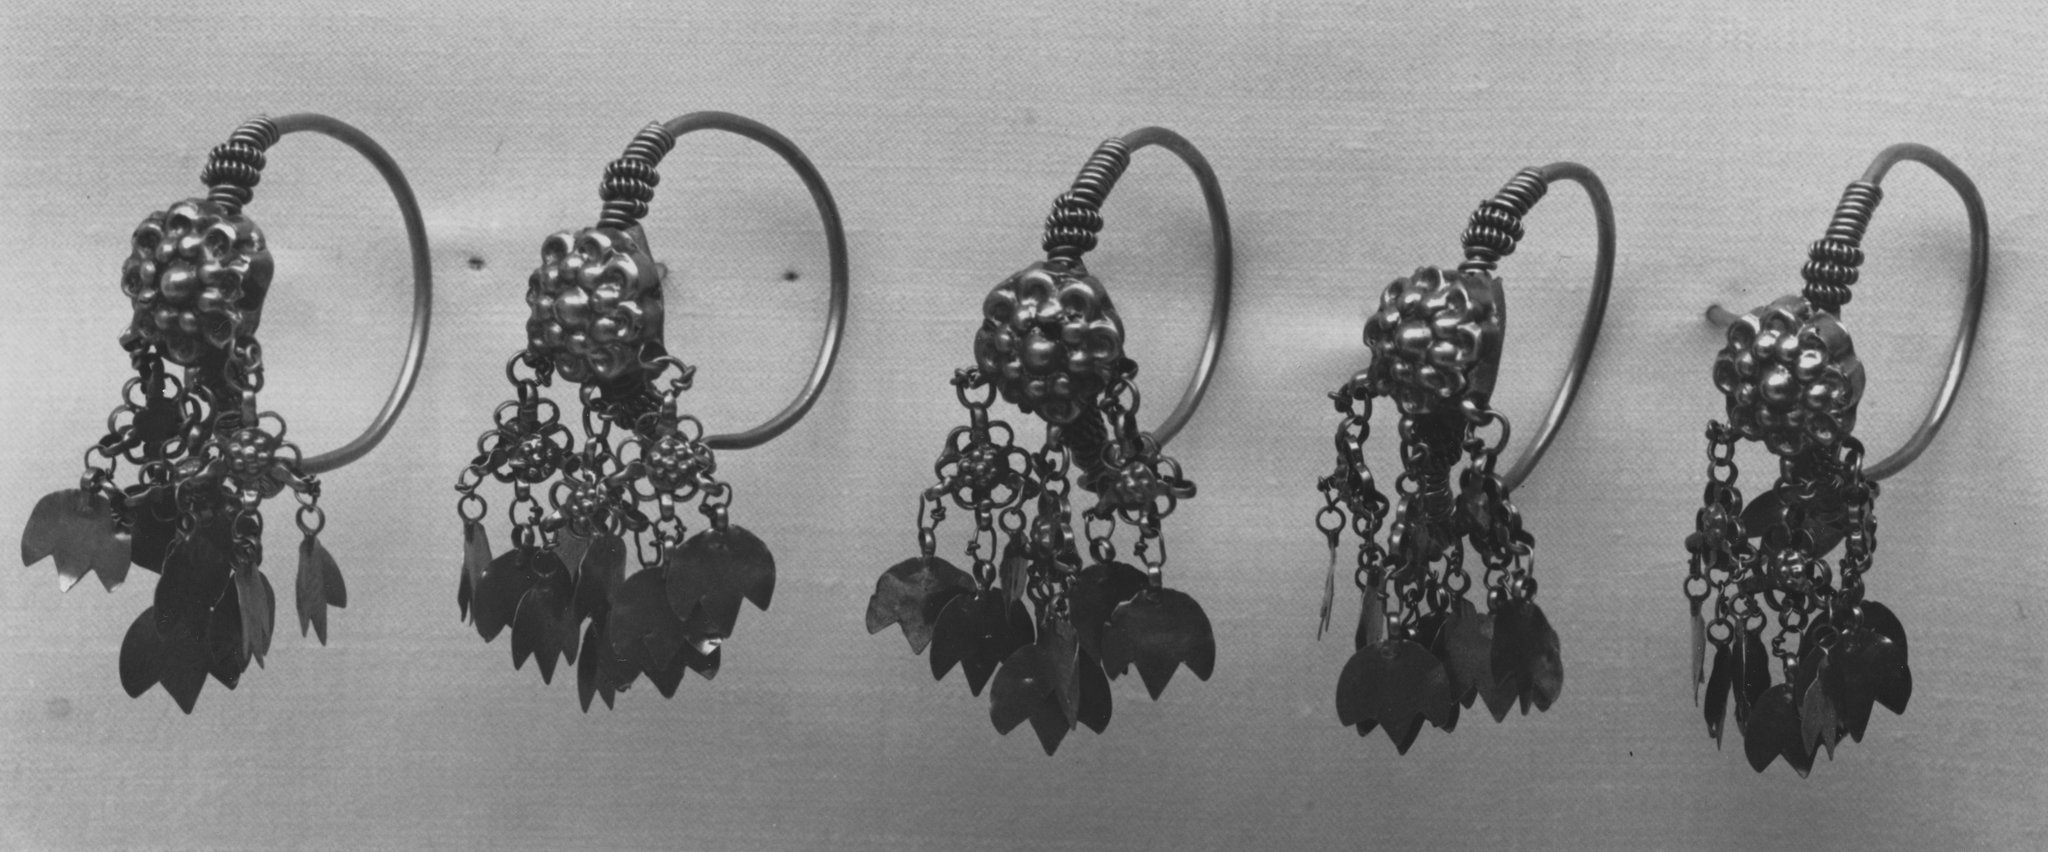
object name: earring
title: Earring, One of a Set of Five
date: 1801-1900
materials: gold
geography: india